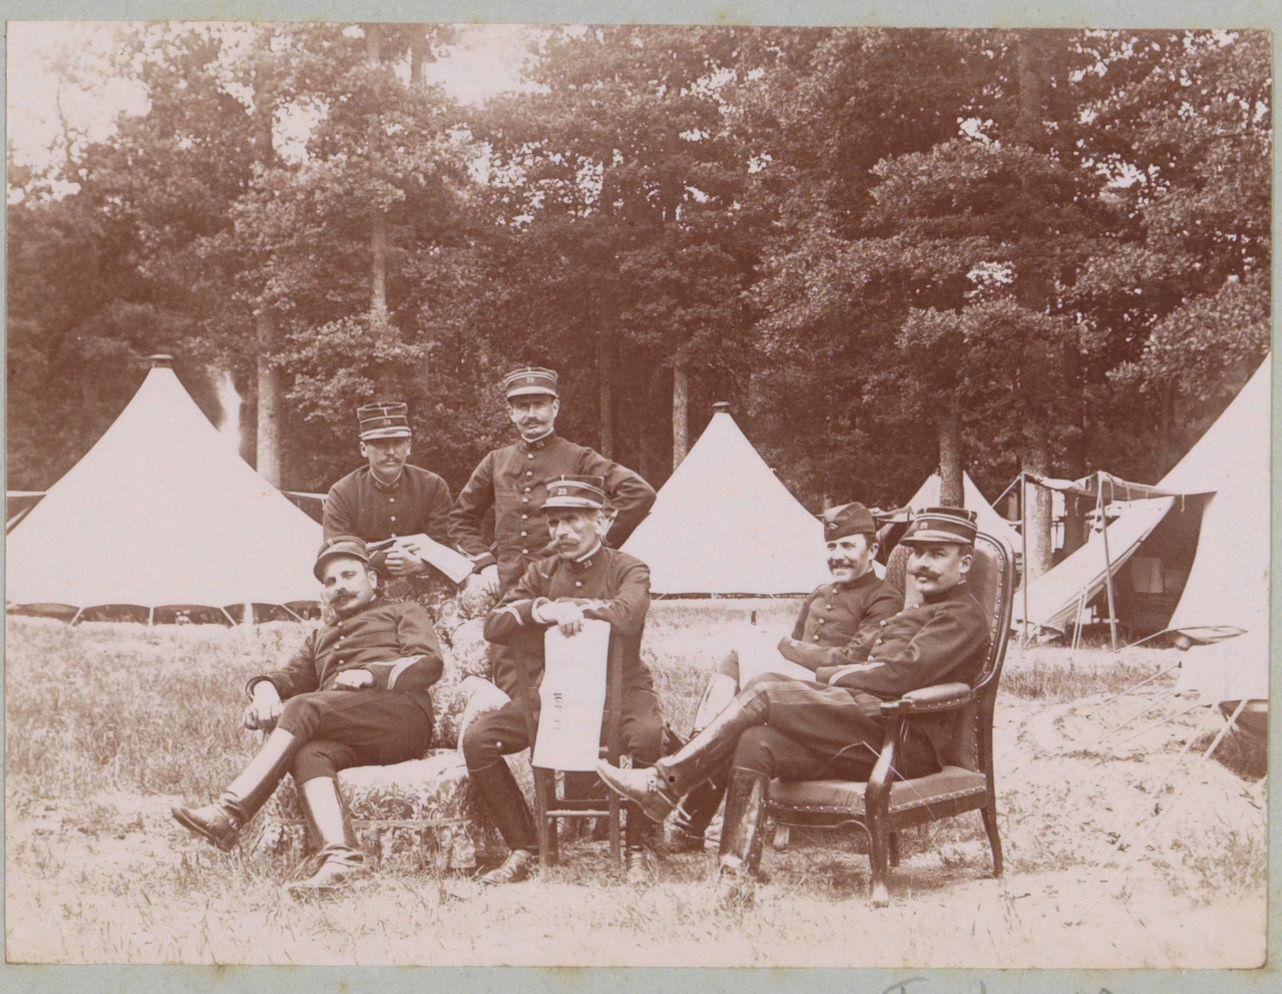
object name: photograph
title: Groepsportret van zes militairen in een legerkamp te Fontainebleau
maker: delizy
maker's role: manufacturer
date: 1806-1896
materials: paper, photographic support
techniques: gelatin silver print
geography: fontainebleau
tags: land forces (+ cavalry, horsemen), (military) camp with tents, (military) uniforms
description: Onderdeel van Fotoalbum van een Franse amateurfotograaf met opnames van uitstapjes in Frankrijk, Spanje, België, Luxemburg en Nederland, de eerste automobielen en autoraces.